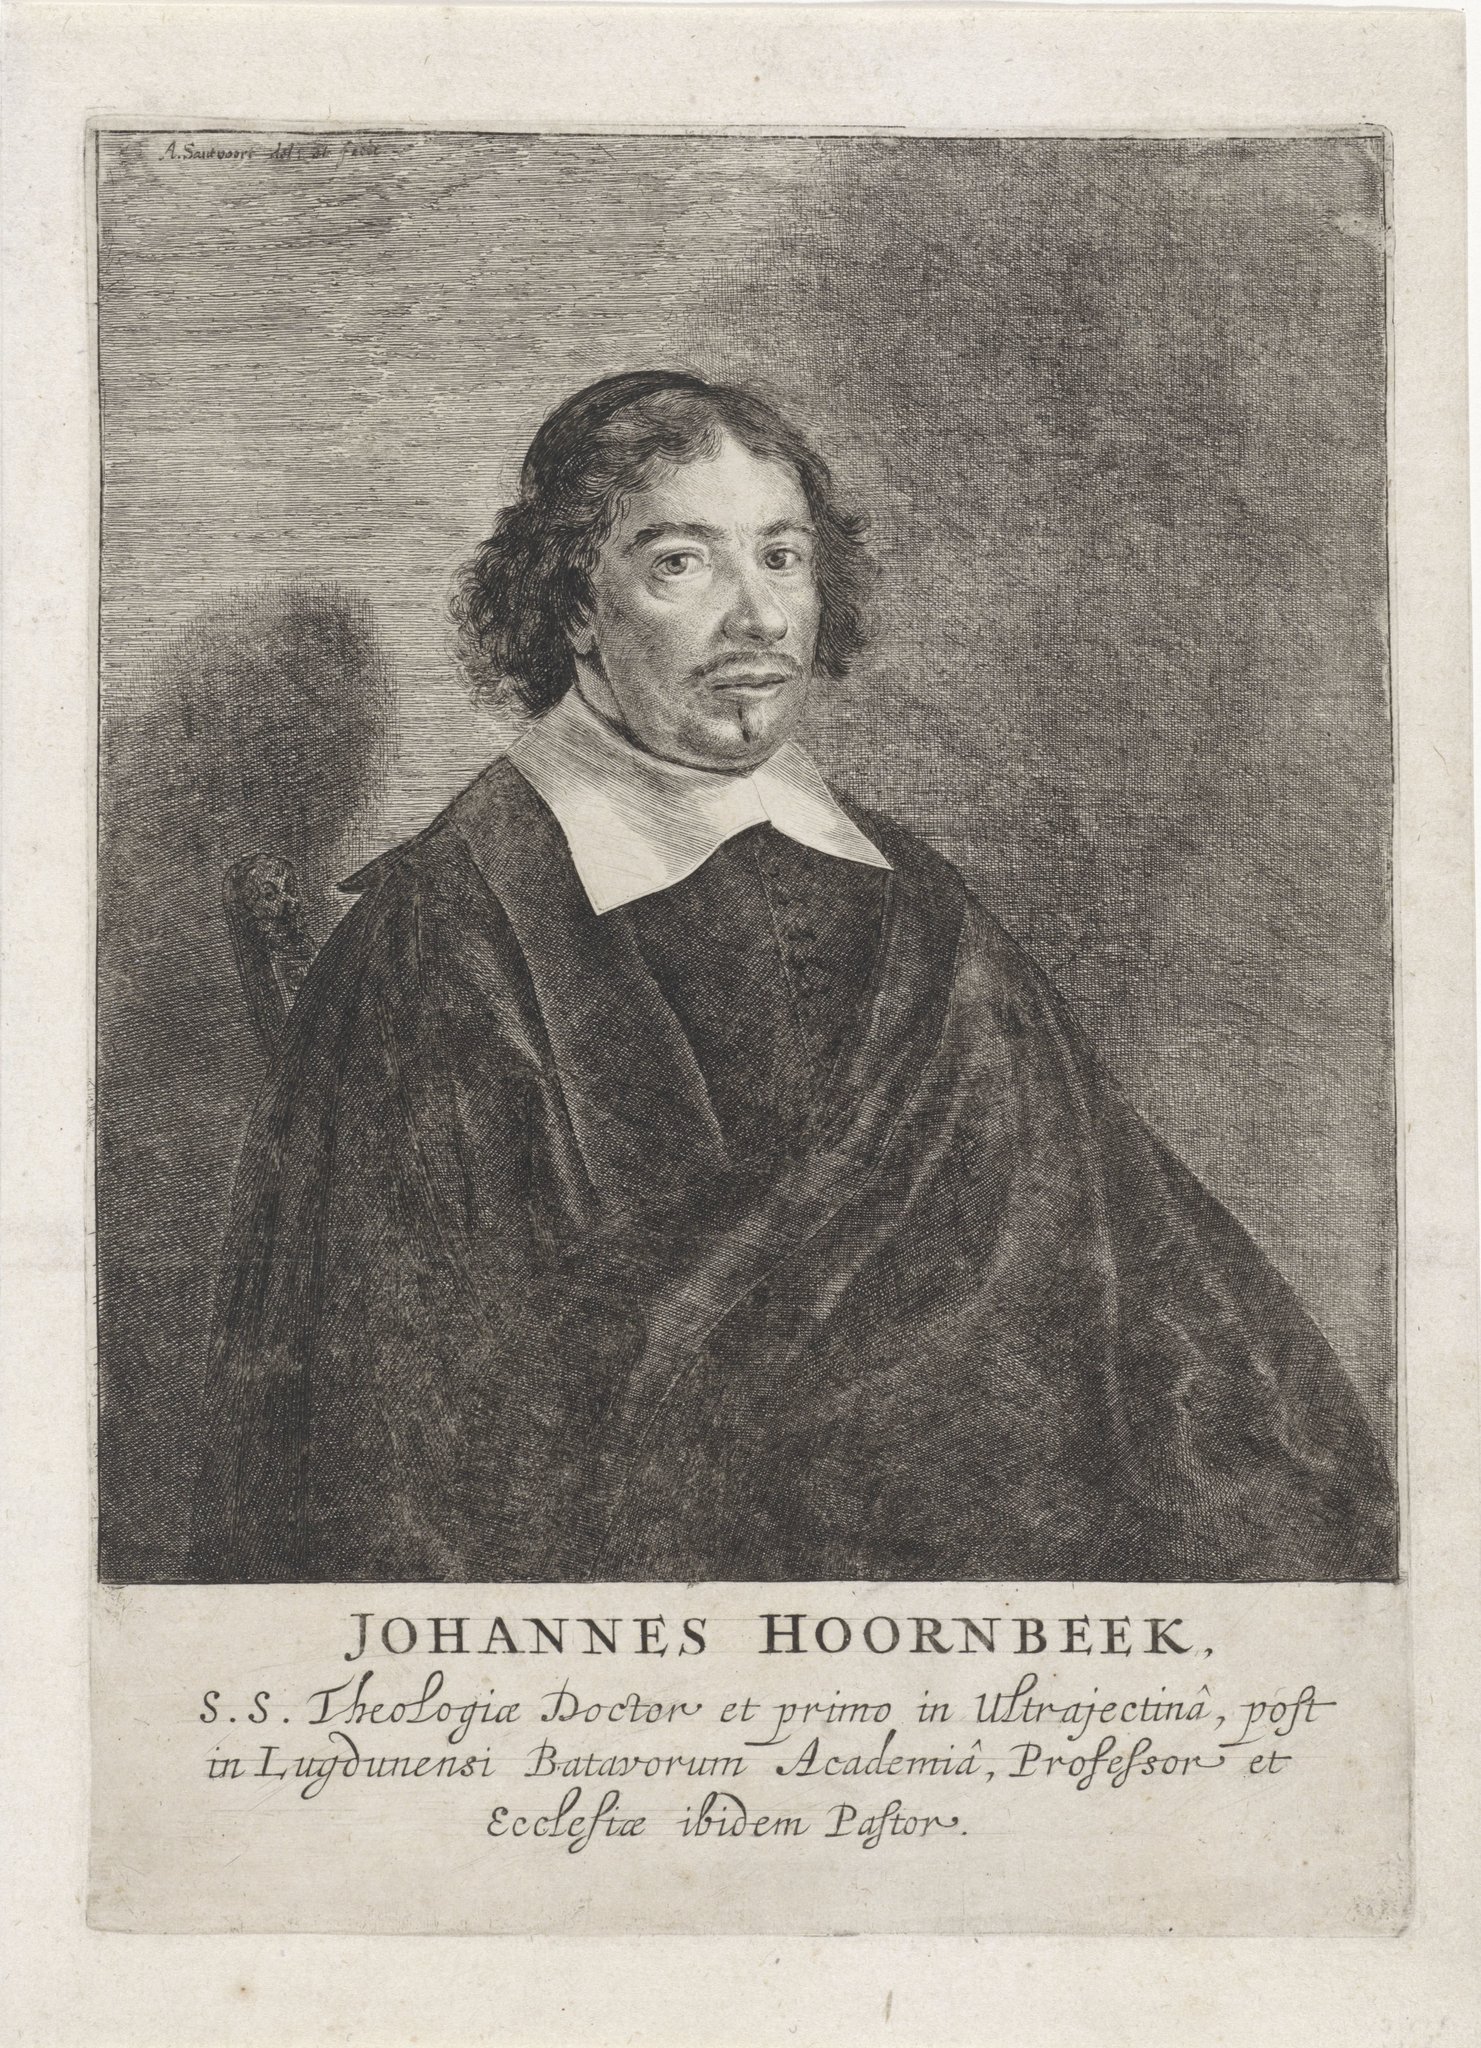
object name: print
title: Portret van Johannes Hoornbeeck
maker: abraham dircksz. santvoort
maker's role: print maker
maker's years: 1614-1669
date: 1654-1666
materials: paper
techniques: etching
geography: netherlands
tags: haarlem, johannes hoornbeeck, historical persons, sitting on an elevation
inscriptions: collector's mark: Lugt 2166, collector's mark: Lugt 2760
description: Portret naar rechts van de hoogleraar theologie Johannes Hoornbeeck, zittend op een stoel. Onder de voorstelling de naam van de geportretteerde en een drieregelige, Latijnse tekst met zijn functies.